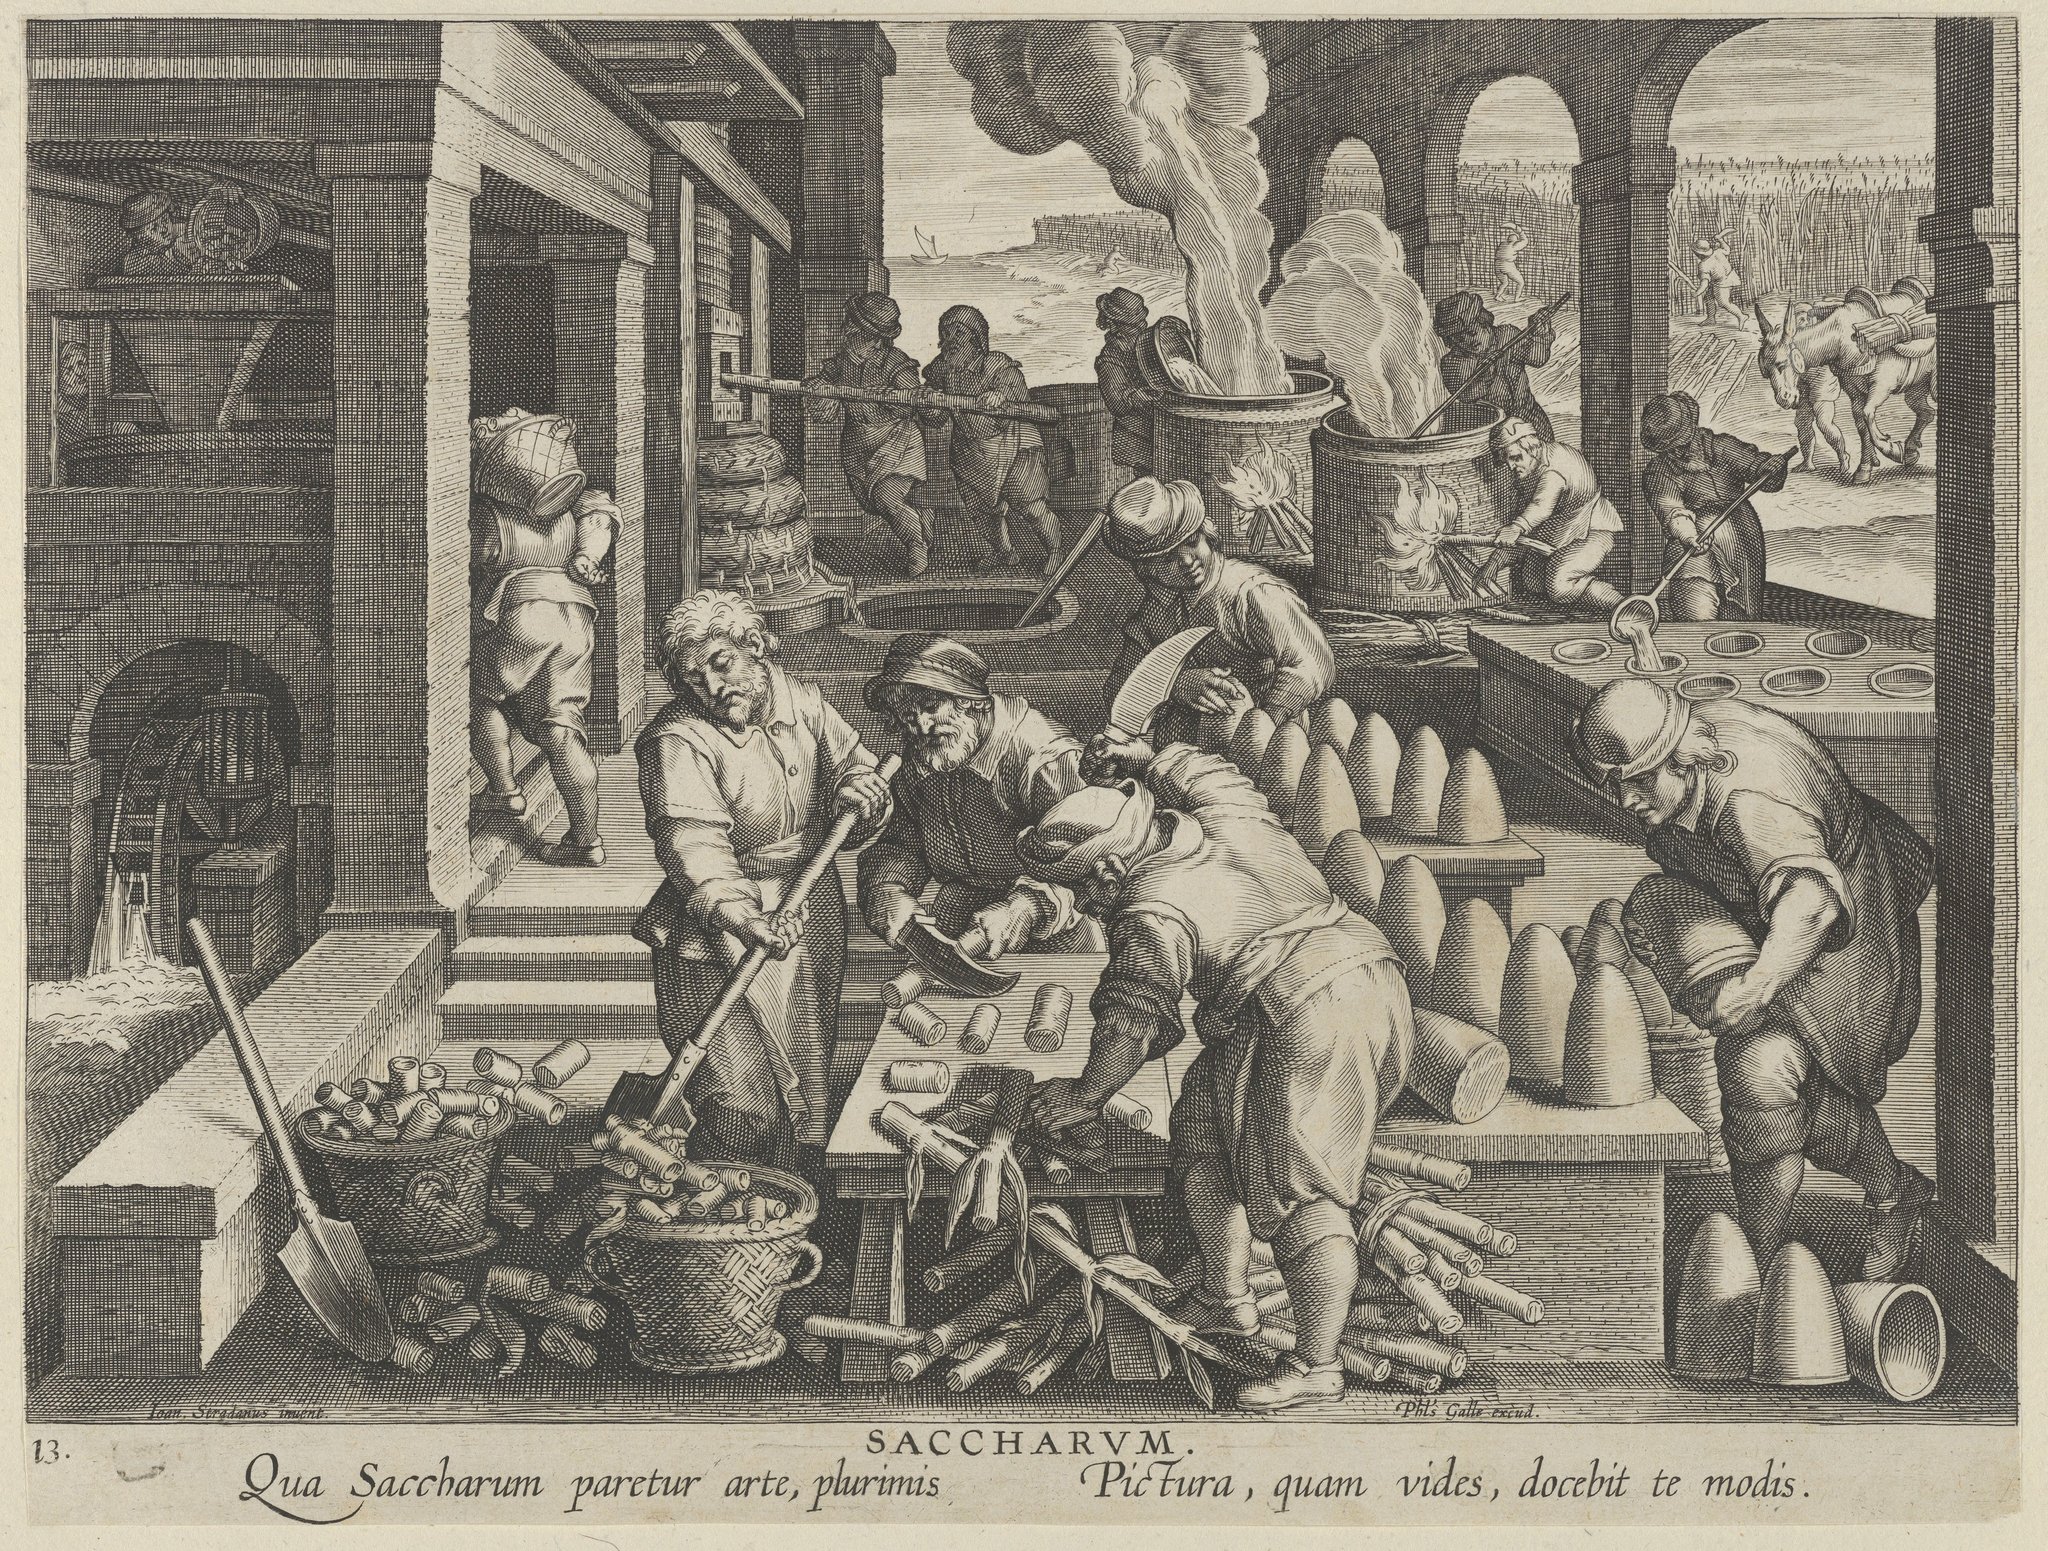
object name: print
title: New Inventions of Modern Times [Nova Reperta], The Invention of Sugar Refinery, plate 13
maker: jan collaert i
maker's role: artist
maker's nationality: netherlandish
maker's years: 1530-1581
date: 1600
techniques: engraving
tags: factories,men,working